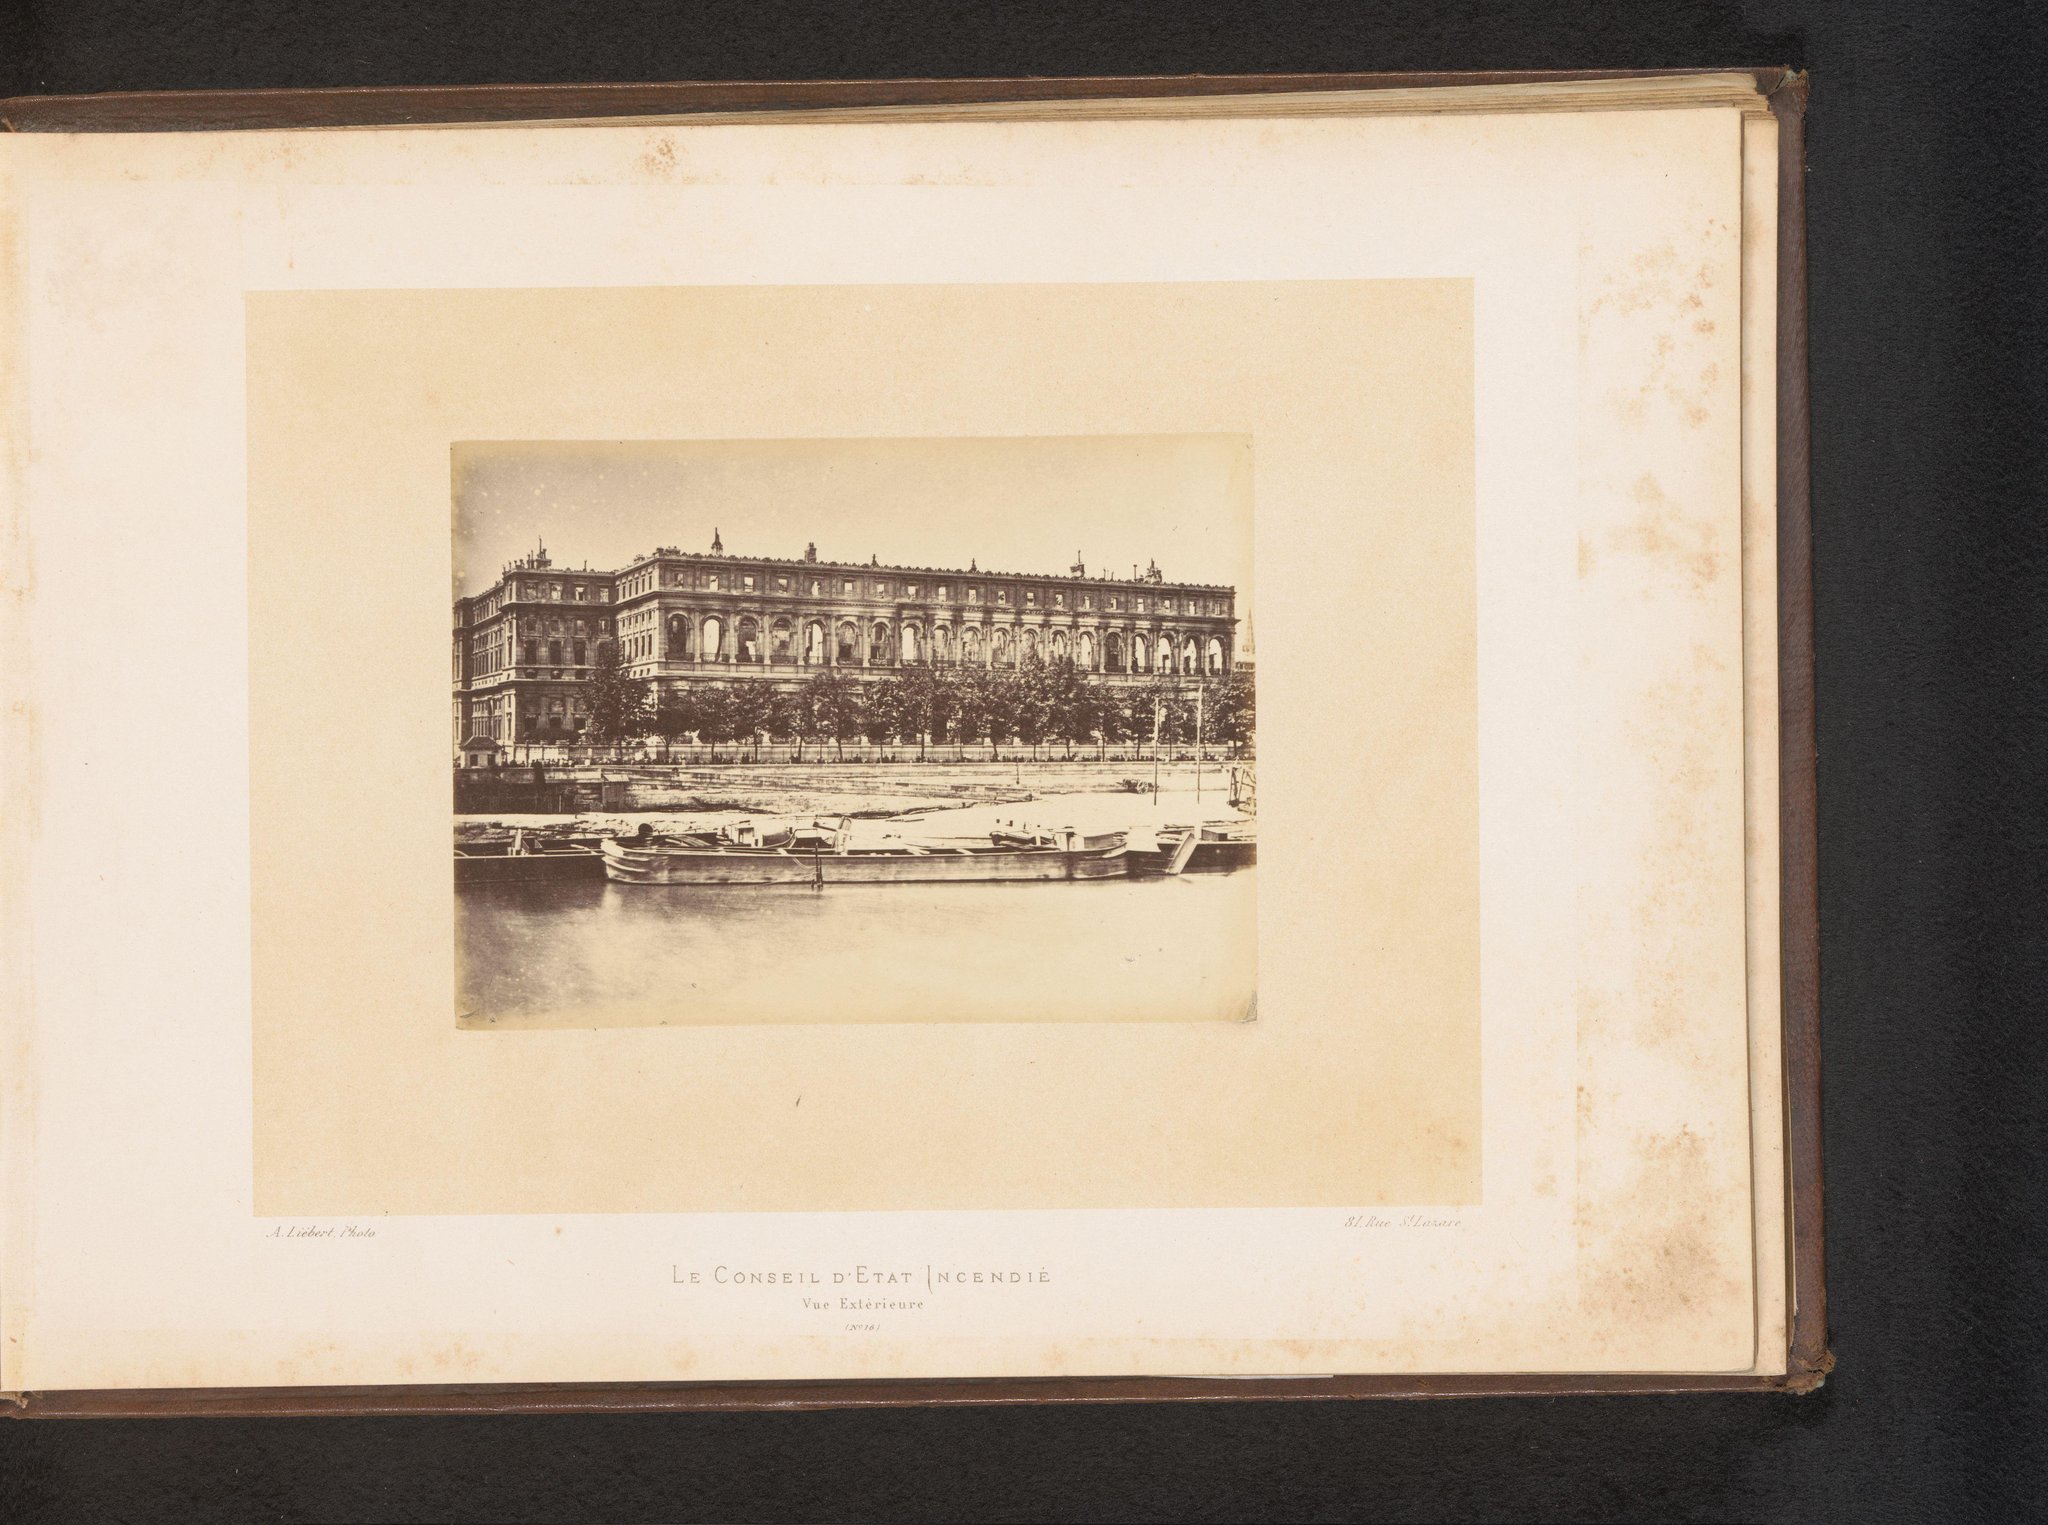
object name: page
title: Gezicht op de Raad van State in Parijs na de brand door de Commune van Parijs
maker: alphonse-justin liébert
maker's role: fotograaf, marinier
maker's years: 1827-1914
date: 1871-1872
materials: photographic support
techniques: albumen print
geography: paris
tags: ruin of a building ~ architecture, national government, paris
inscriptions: number: ‘(No. 16)’, address: ‘31, Rue St. Lazare’